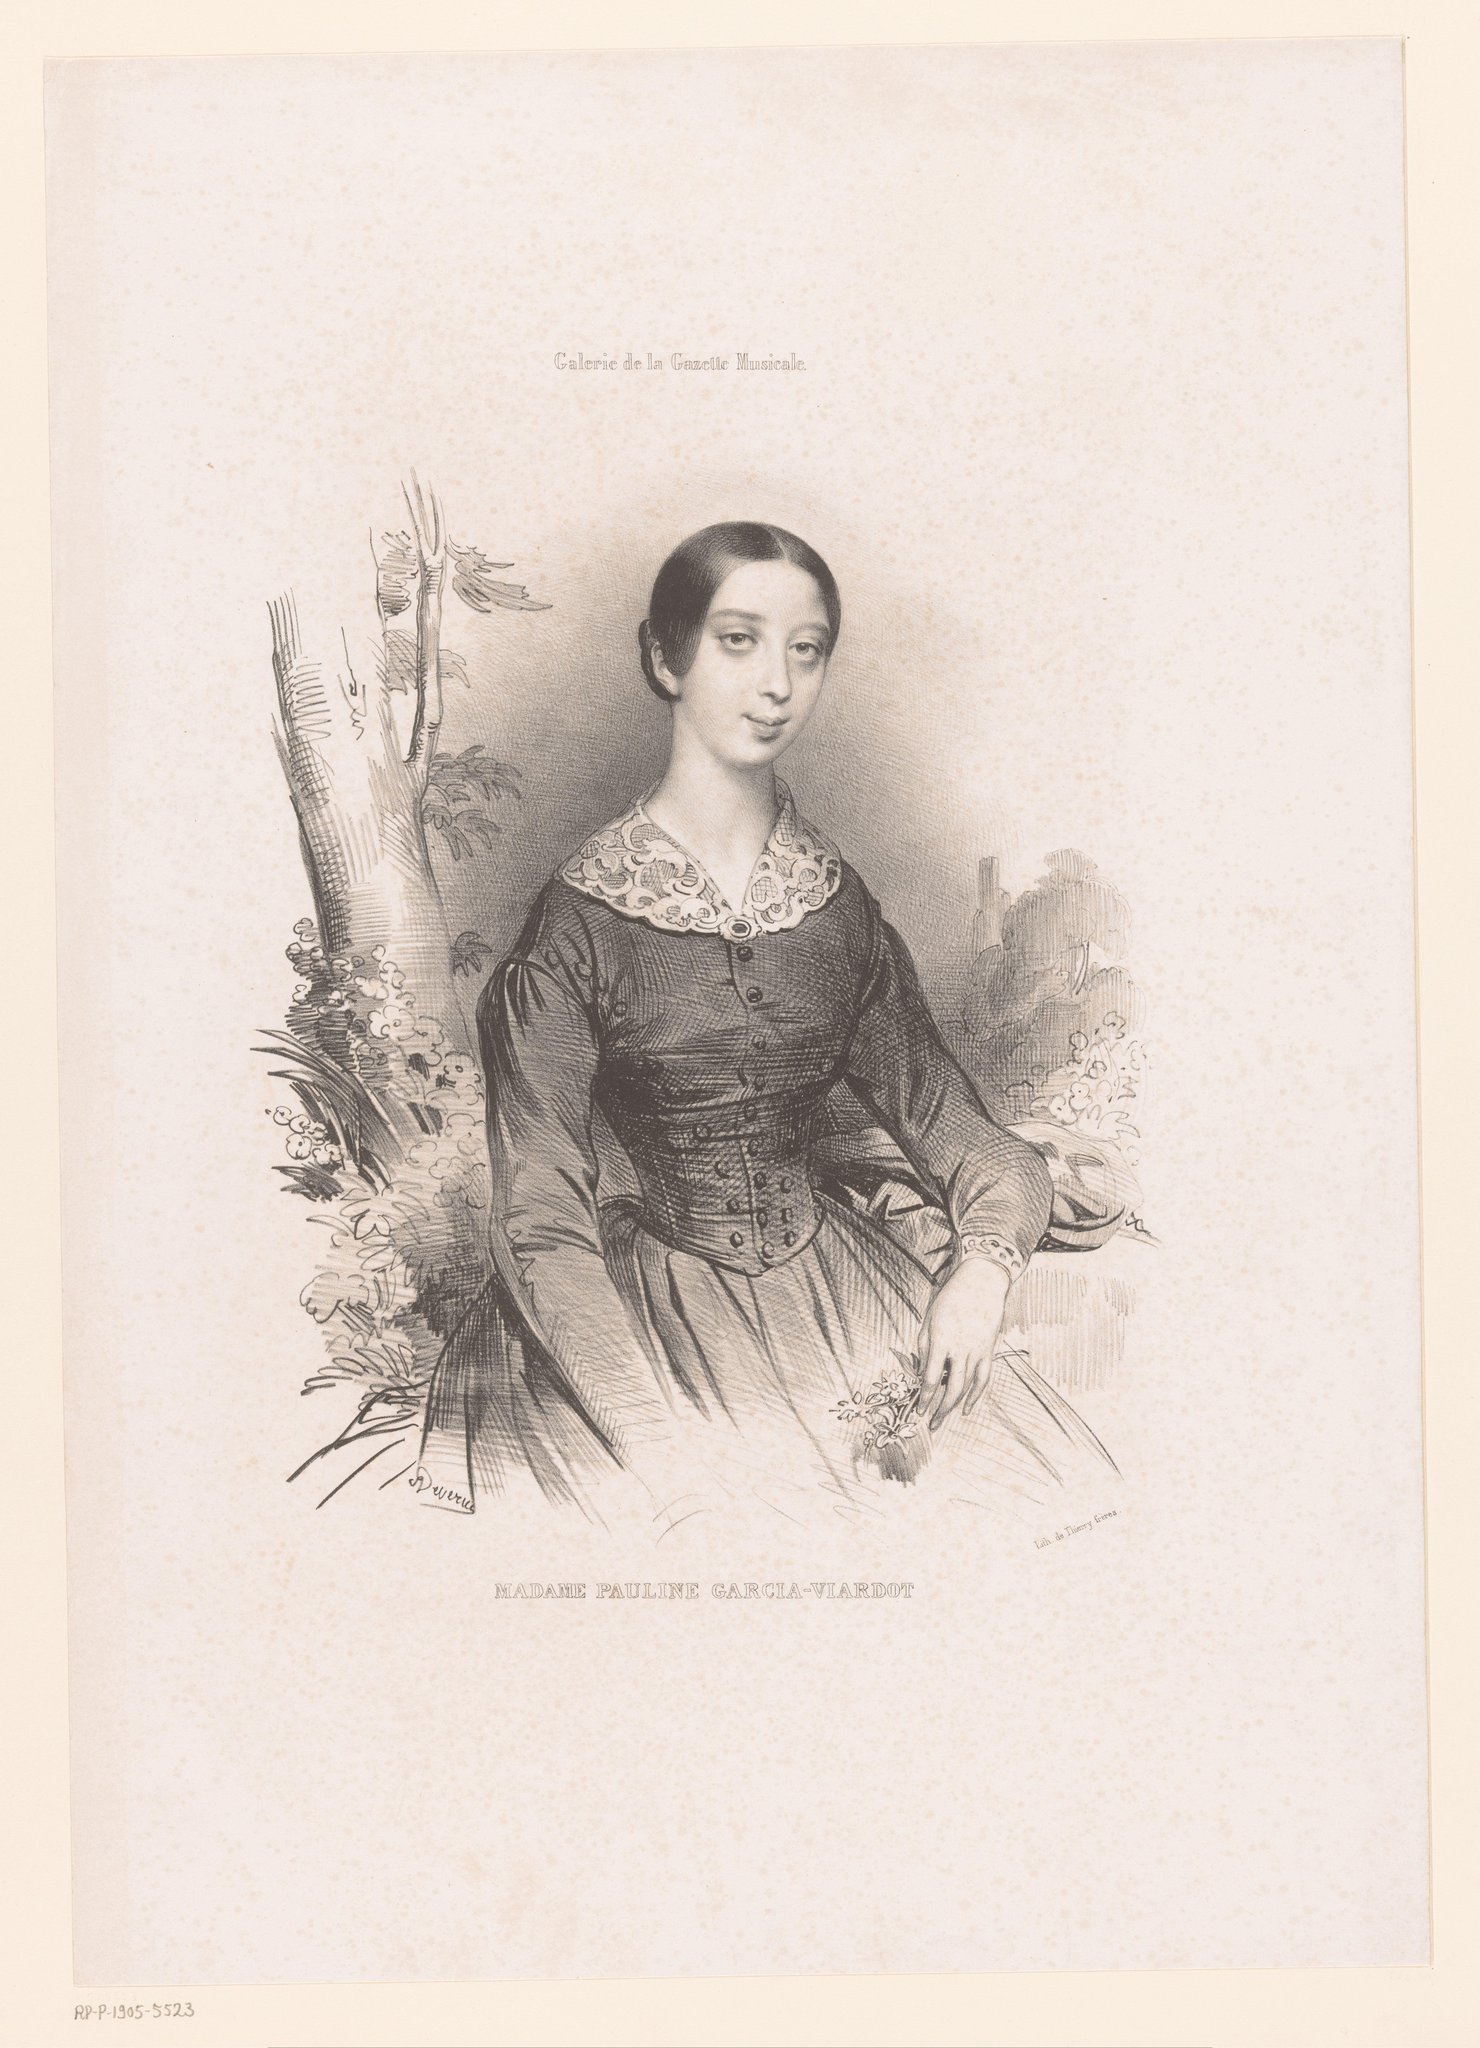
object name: print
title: Madame Pauline Garcia-Viardot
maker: achille devéria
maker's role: draughtsman, painter, print maker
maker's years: 1800-1857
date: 1840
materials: paper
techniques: lithograph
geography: paris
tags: pauline viardot-garcia, historical persons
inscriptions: collector's mark: Lugt 2228a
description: Prent gebruikt voor: Galerie de la Gazette Musicale.